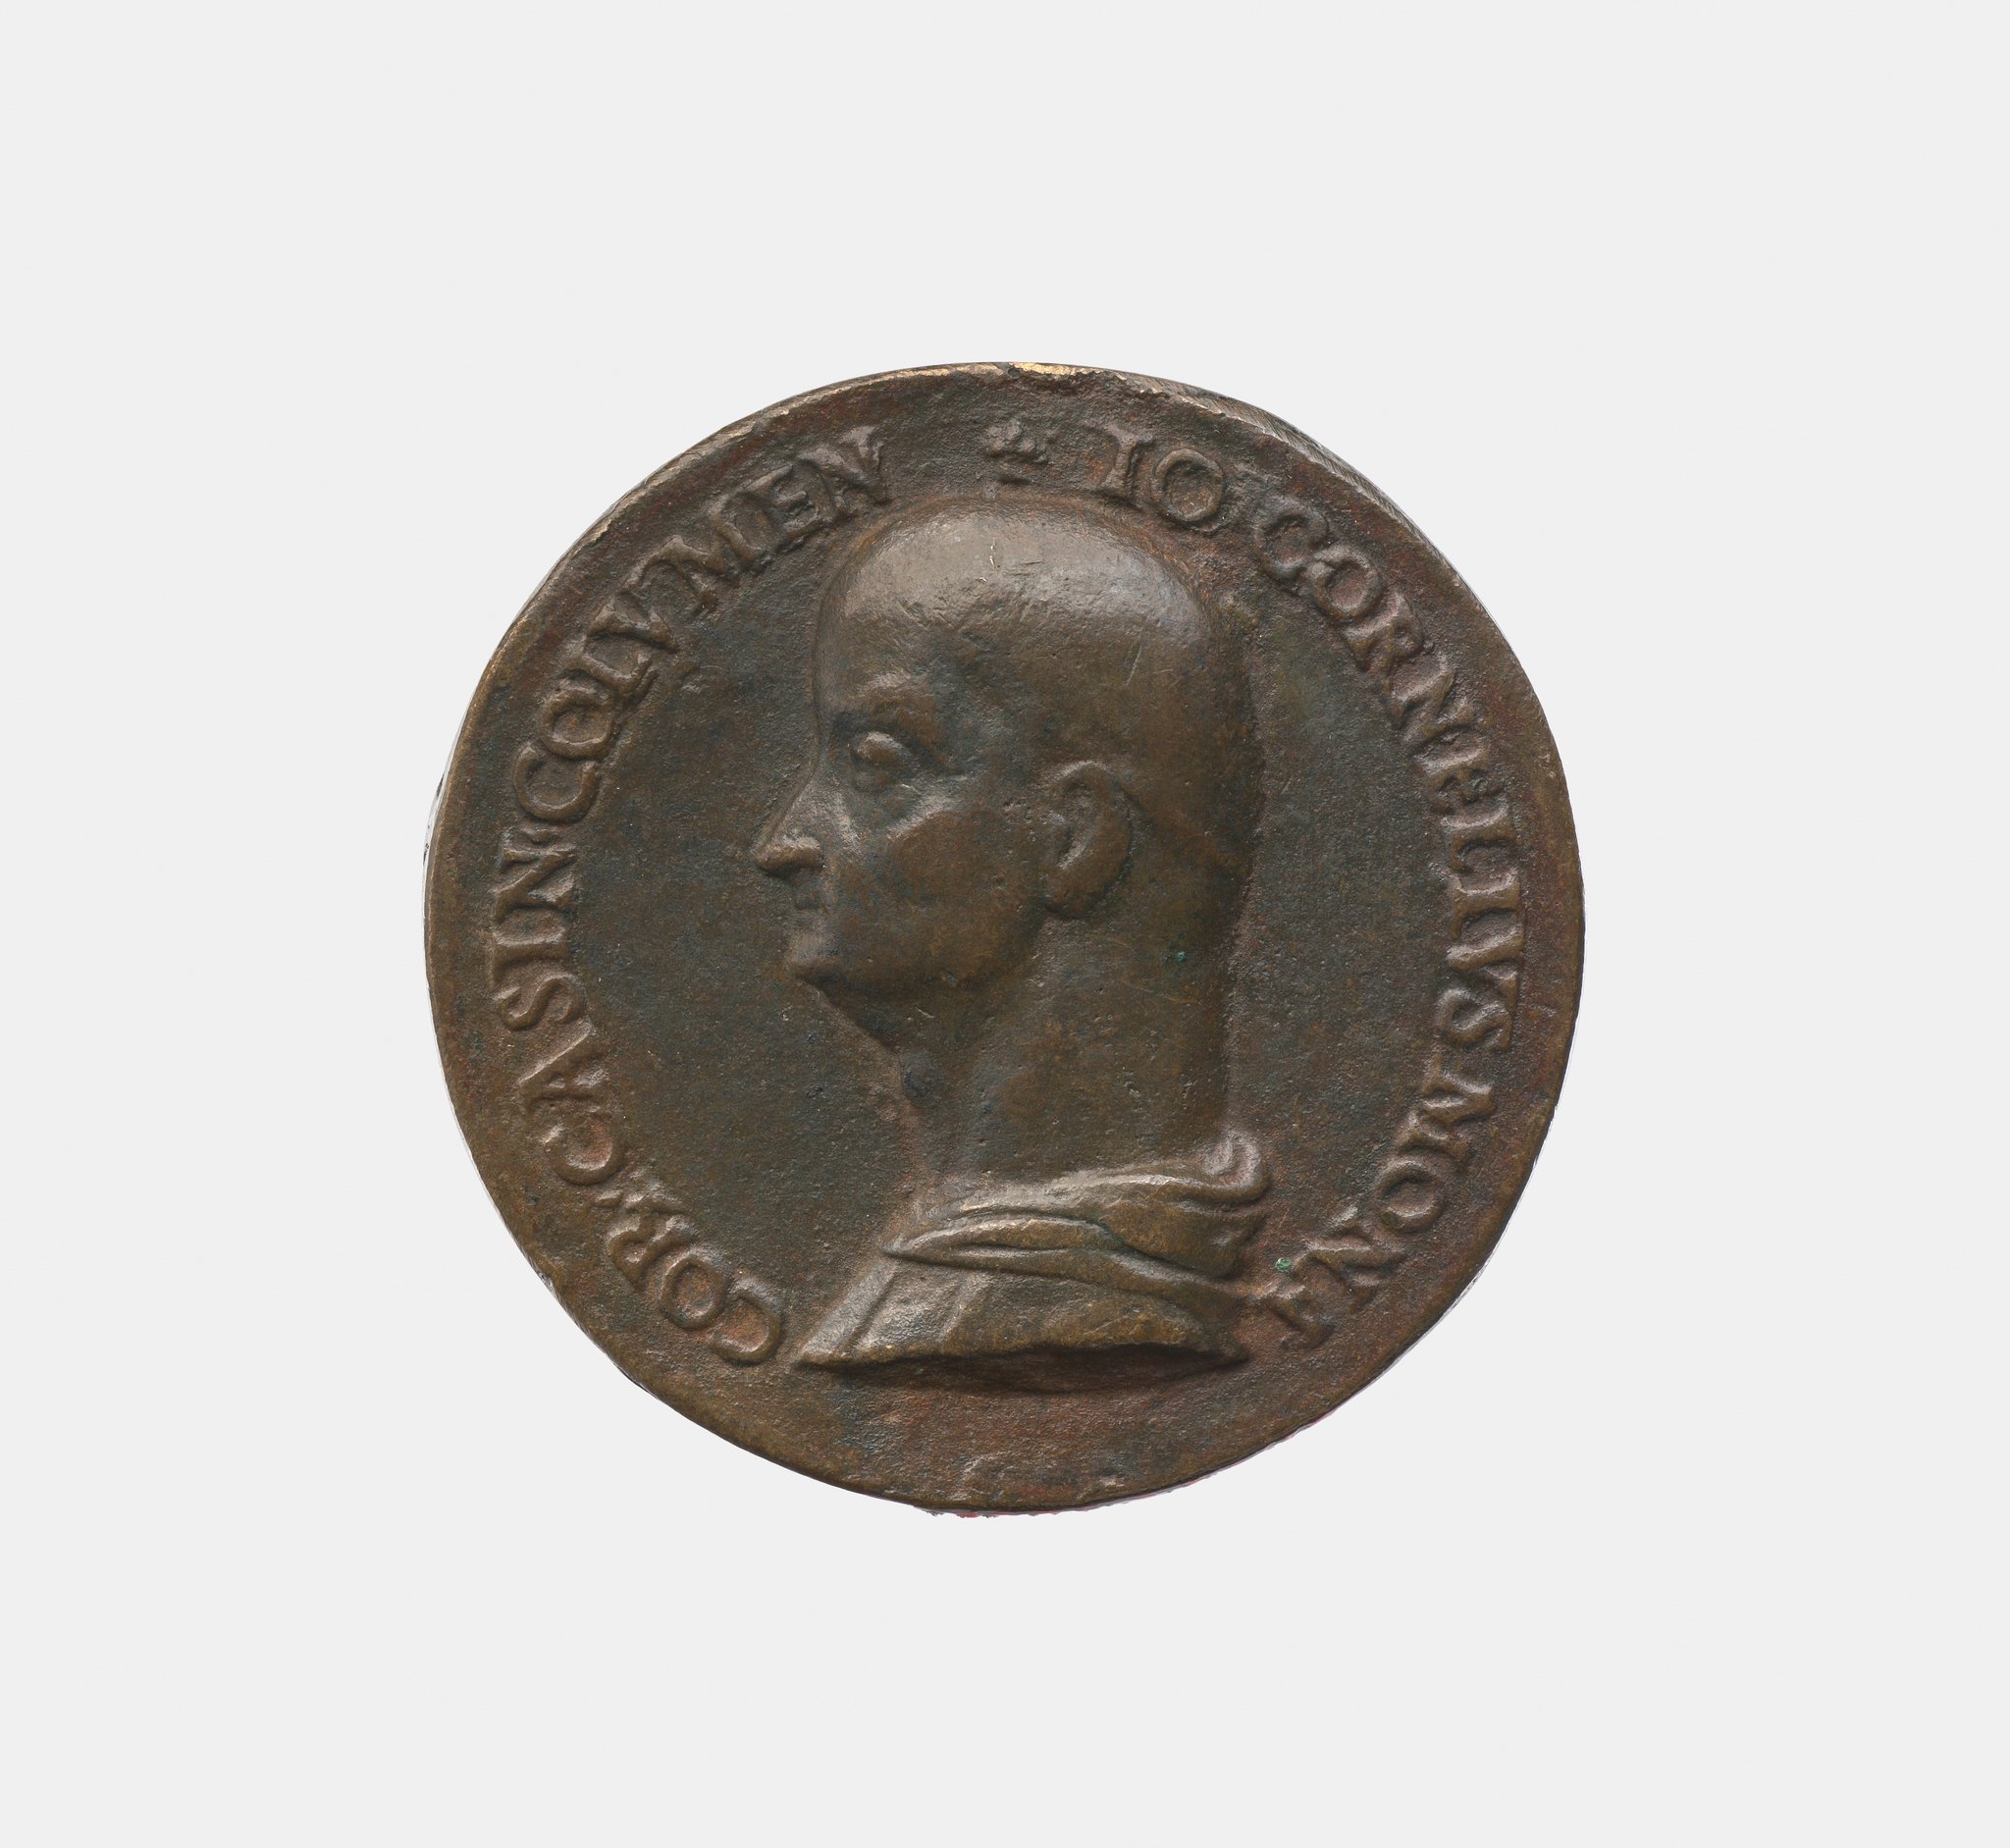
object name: medal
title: Fra Giovanni Cornaro, Venetian Benedictine of the Abbey of Praglia, Abbot of Santa Giustina of Padua 1507-14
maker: Anonymous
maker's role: artist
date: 1507-1514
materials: bronze